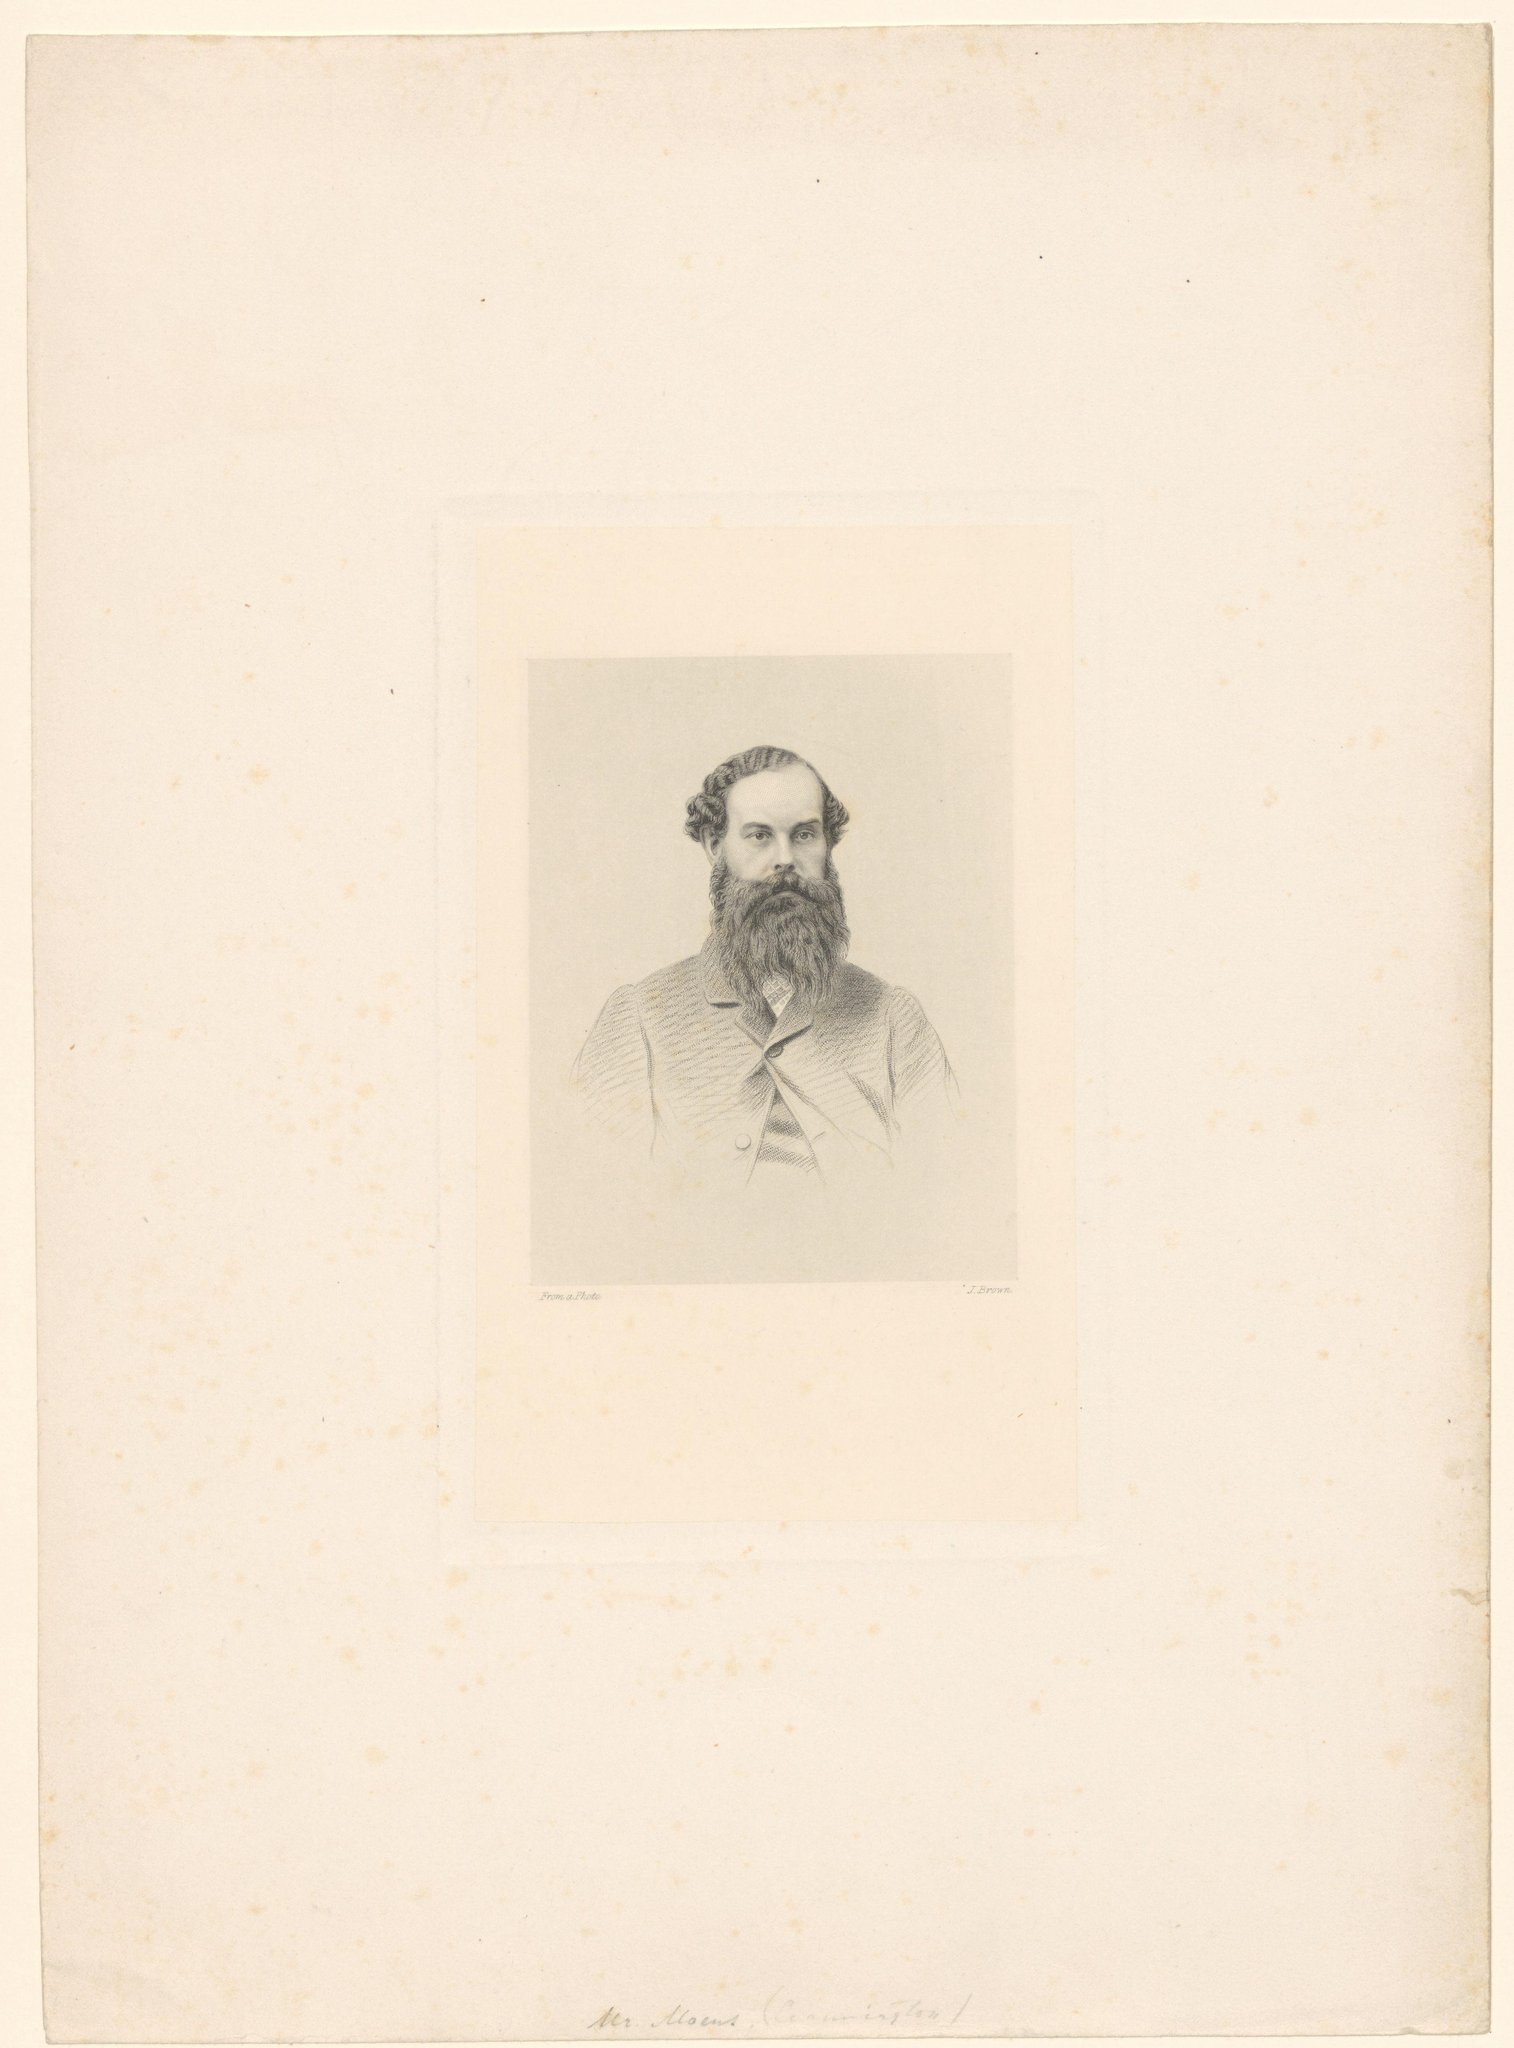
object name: print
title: Portret van William John Charles Möens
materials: paper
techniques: printmaking, engraving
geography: london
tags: historical persons, portrait of a writer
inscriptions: collector's mark: Lugt 2228